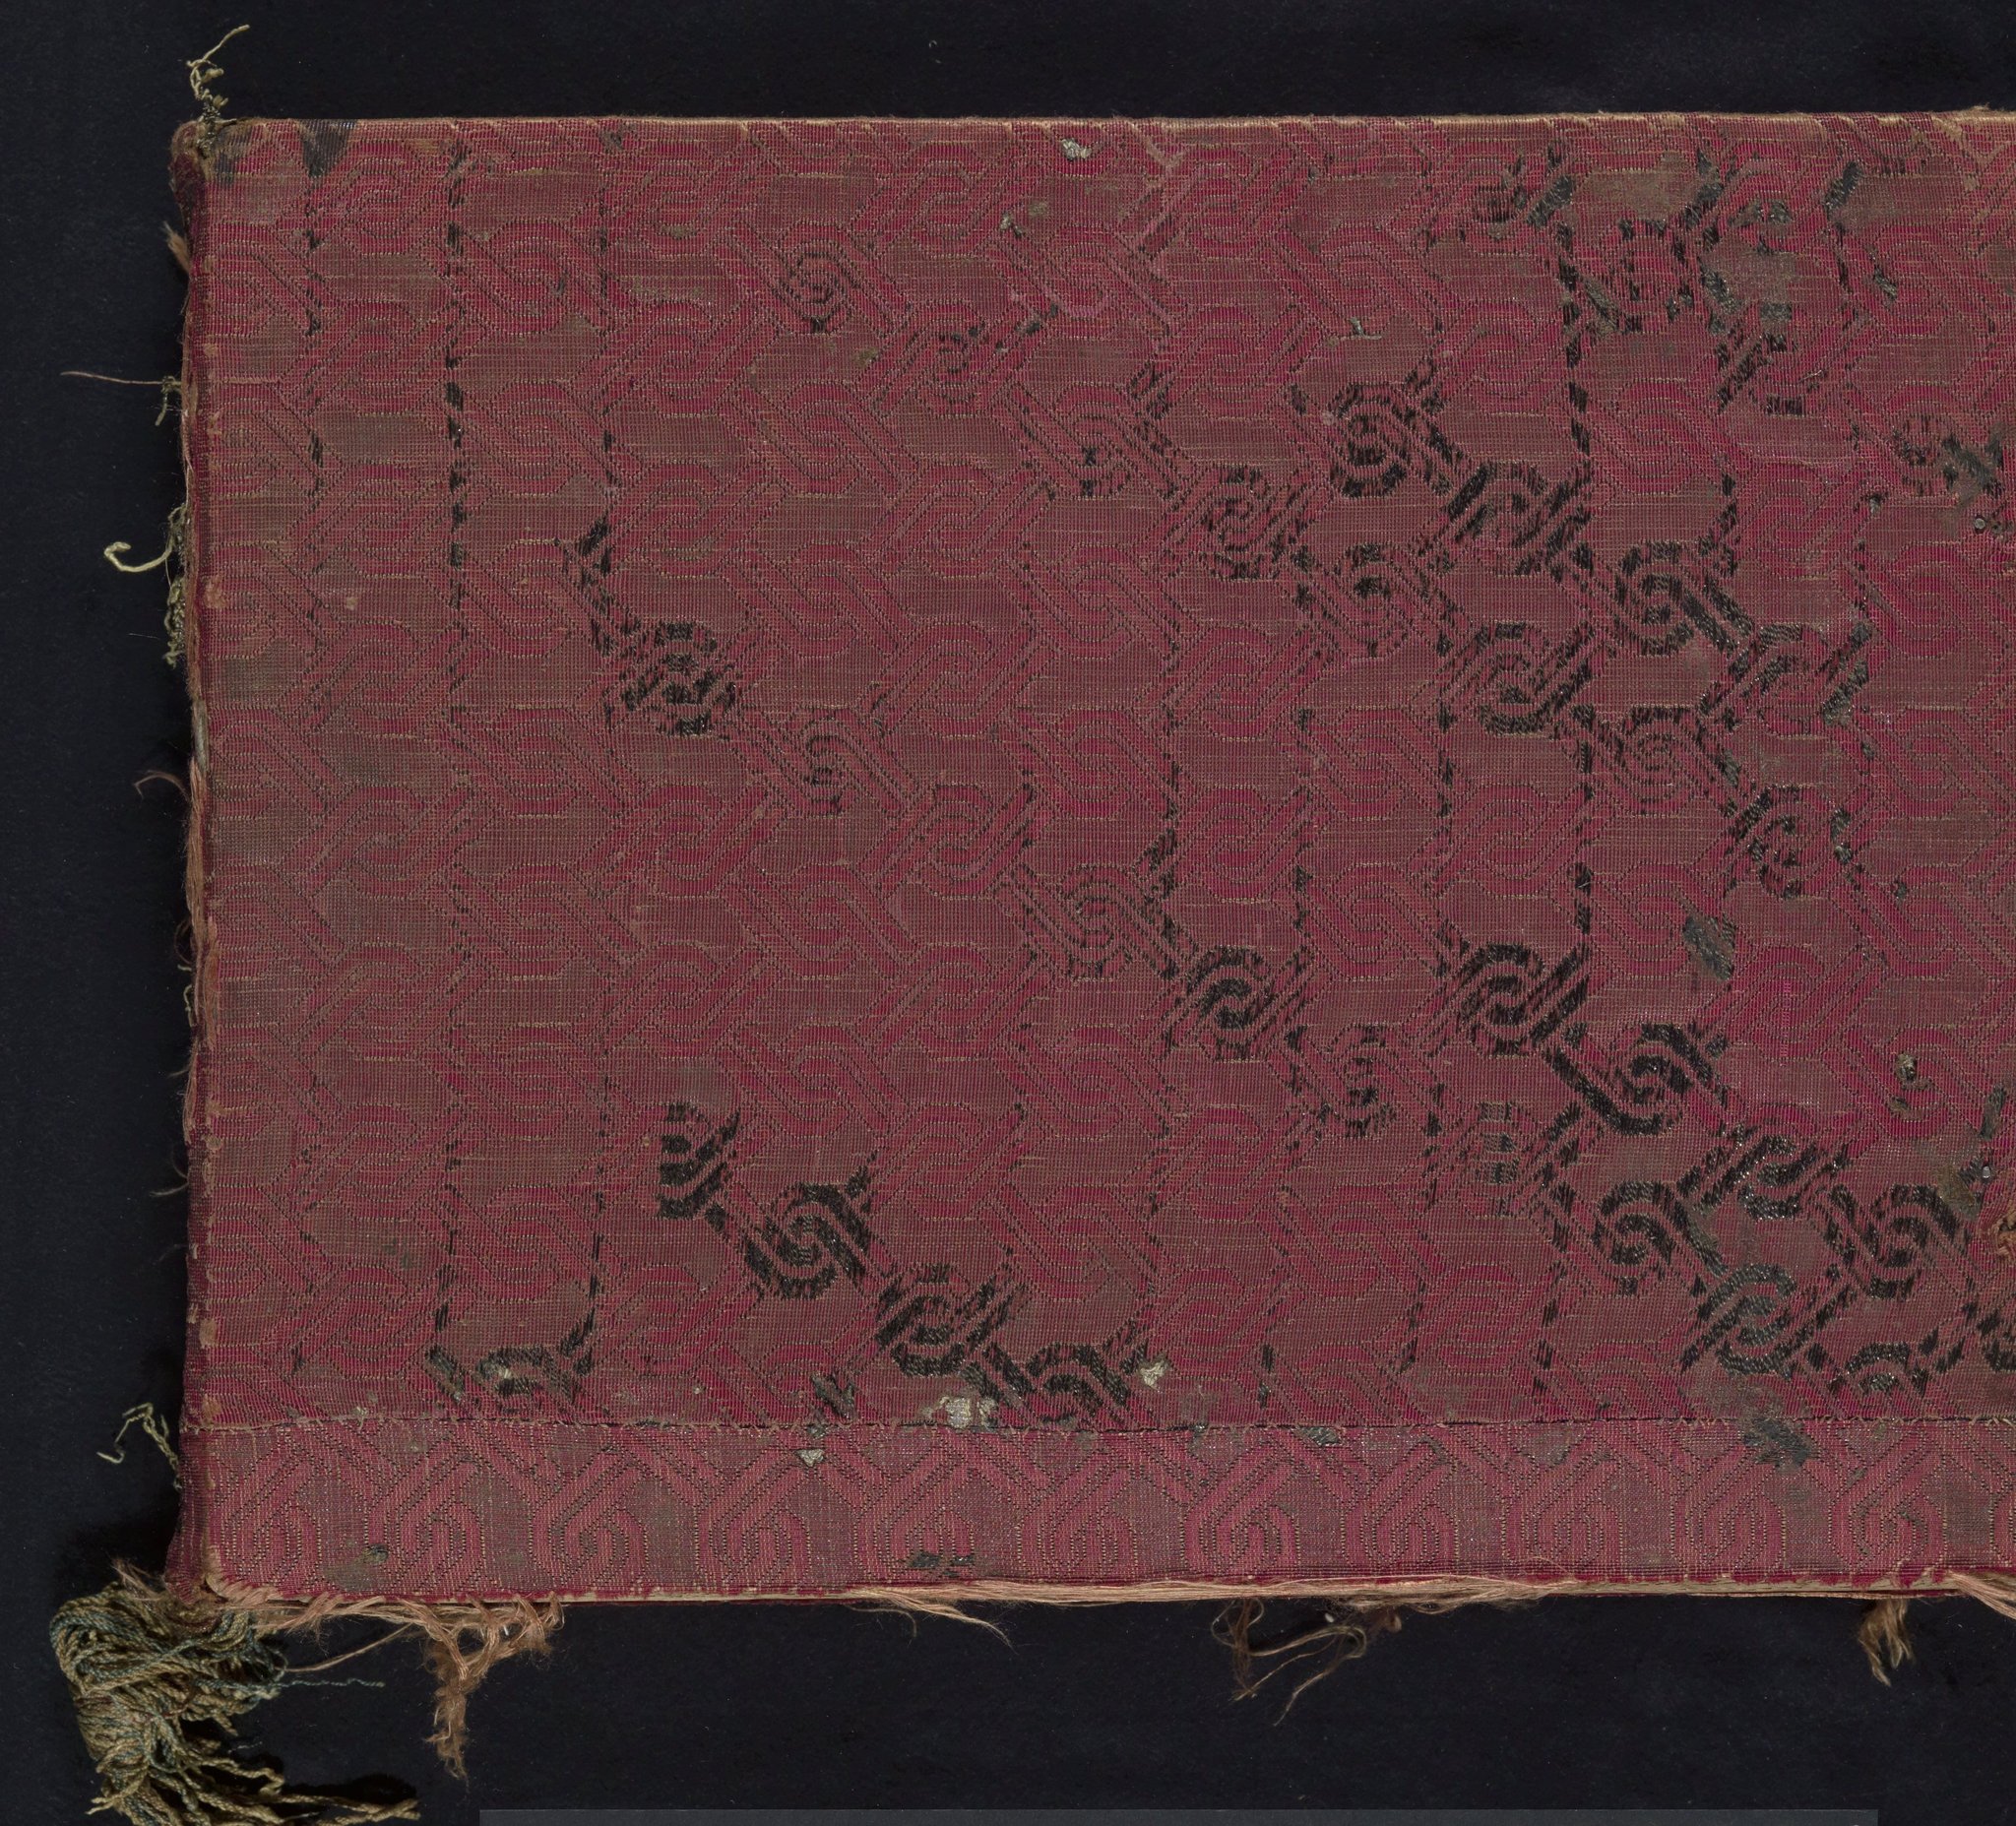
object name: tekeningenalbum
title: Album met voorstellingen van tulpen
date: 1637-1645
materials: paint, paper, parchment, pencil, textile, watercolor, wood, yarns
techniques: bookbinding, brush, embroidered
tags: flowers: tulip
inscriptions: bookplate: ‘Ex Libris/ Ernst H. Krelage’, collector's mark: Lugt 2228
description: Album met 85 voorstellingen op 97 perkamenten bladen. Twaalf bladen bleven blanco. Elke albumopening (behalve de laatste) toont vier tulpensoorten, twee per blad. Op ieder blad zijn de tulpen aangevuld met insecten, schelpen, bessen en andere bloemen. Op enkele bladen staan het gewicht en de prijzen van de tulpenbollen. Band van rode stof met borduurwerk en franje, voorin en achterin twee papieren schutbladen. Op de verso van het voorste schutblad een contemporaine handgeschreven lijst van de afgebeelde tulpen per opening, genummerd 1 t/m 42. Daaruit blijkt dat de eerste opening (twee bladen) in het album ontbreekt. De laatste drie bladen in dit album worden niet in de lijst genoemd. Op het voorste dekblad het ex libris van Ernst H. Krelage.